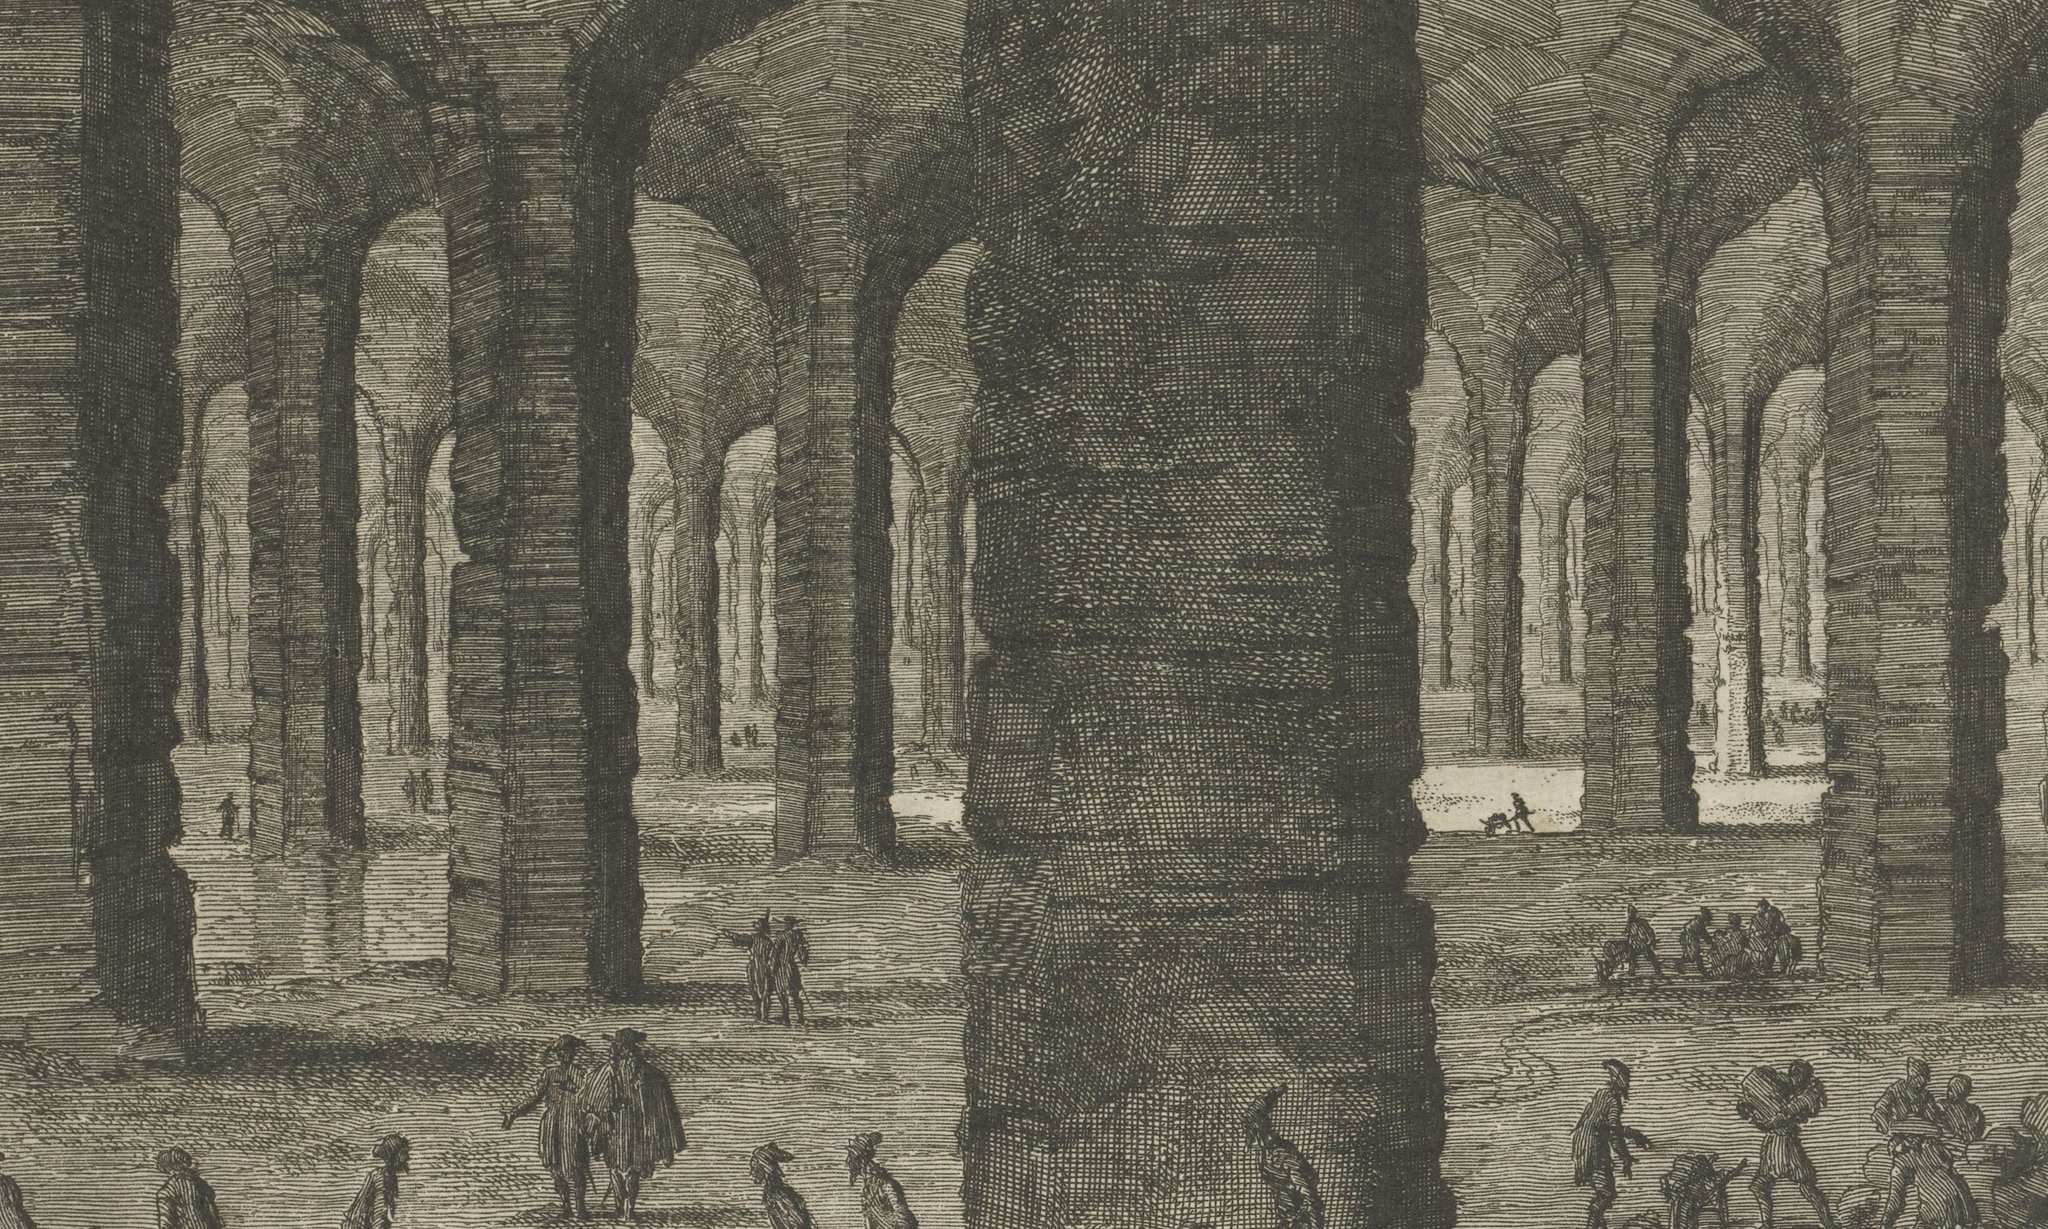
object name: book illustration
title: St Pieters Bergh bij Mastricht, soo als hem die onder de Aerde vertoont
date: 1682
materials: paper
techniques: etching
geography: amsterdam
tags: kinds of non-precious stone: chalk, cave, grotto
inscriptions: collector's mark: Lugt 2228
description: Illustratie opgenomen in: Brown, Edward. Naauwkeurige en gedenkwaardige reysen van Edward Brown (...) door Nederland, Duytsland, Hongaryen, Boek III, p. 112. Amsterdam: Jan Claesz ten Hoorn, 1682.